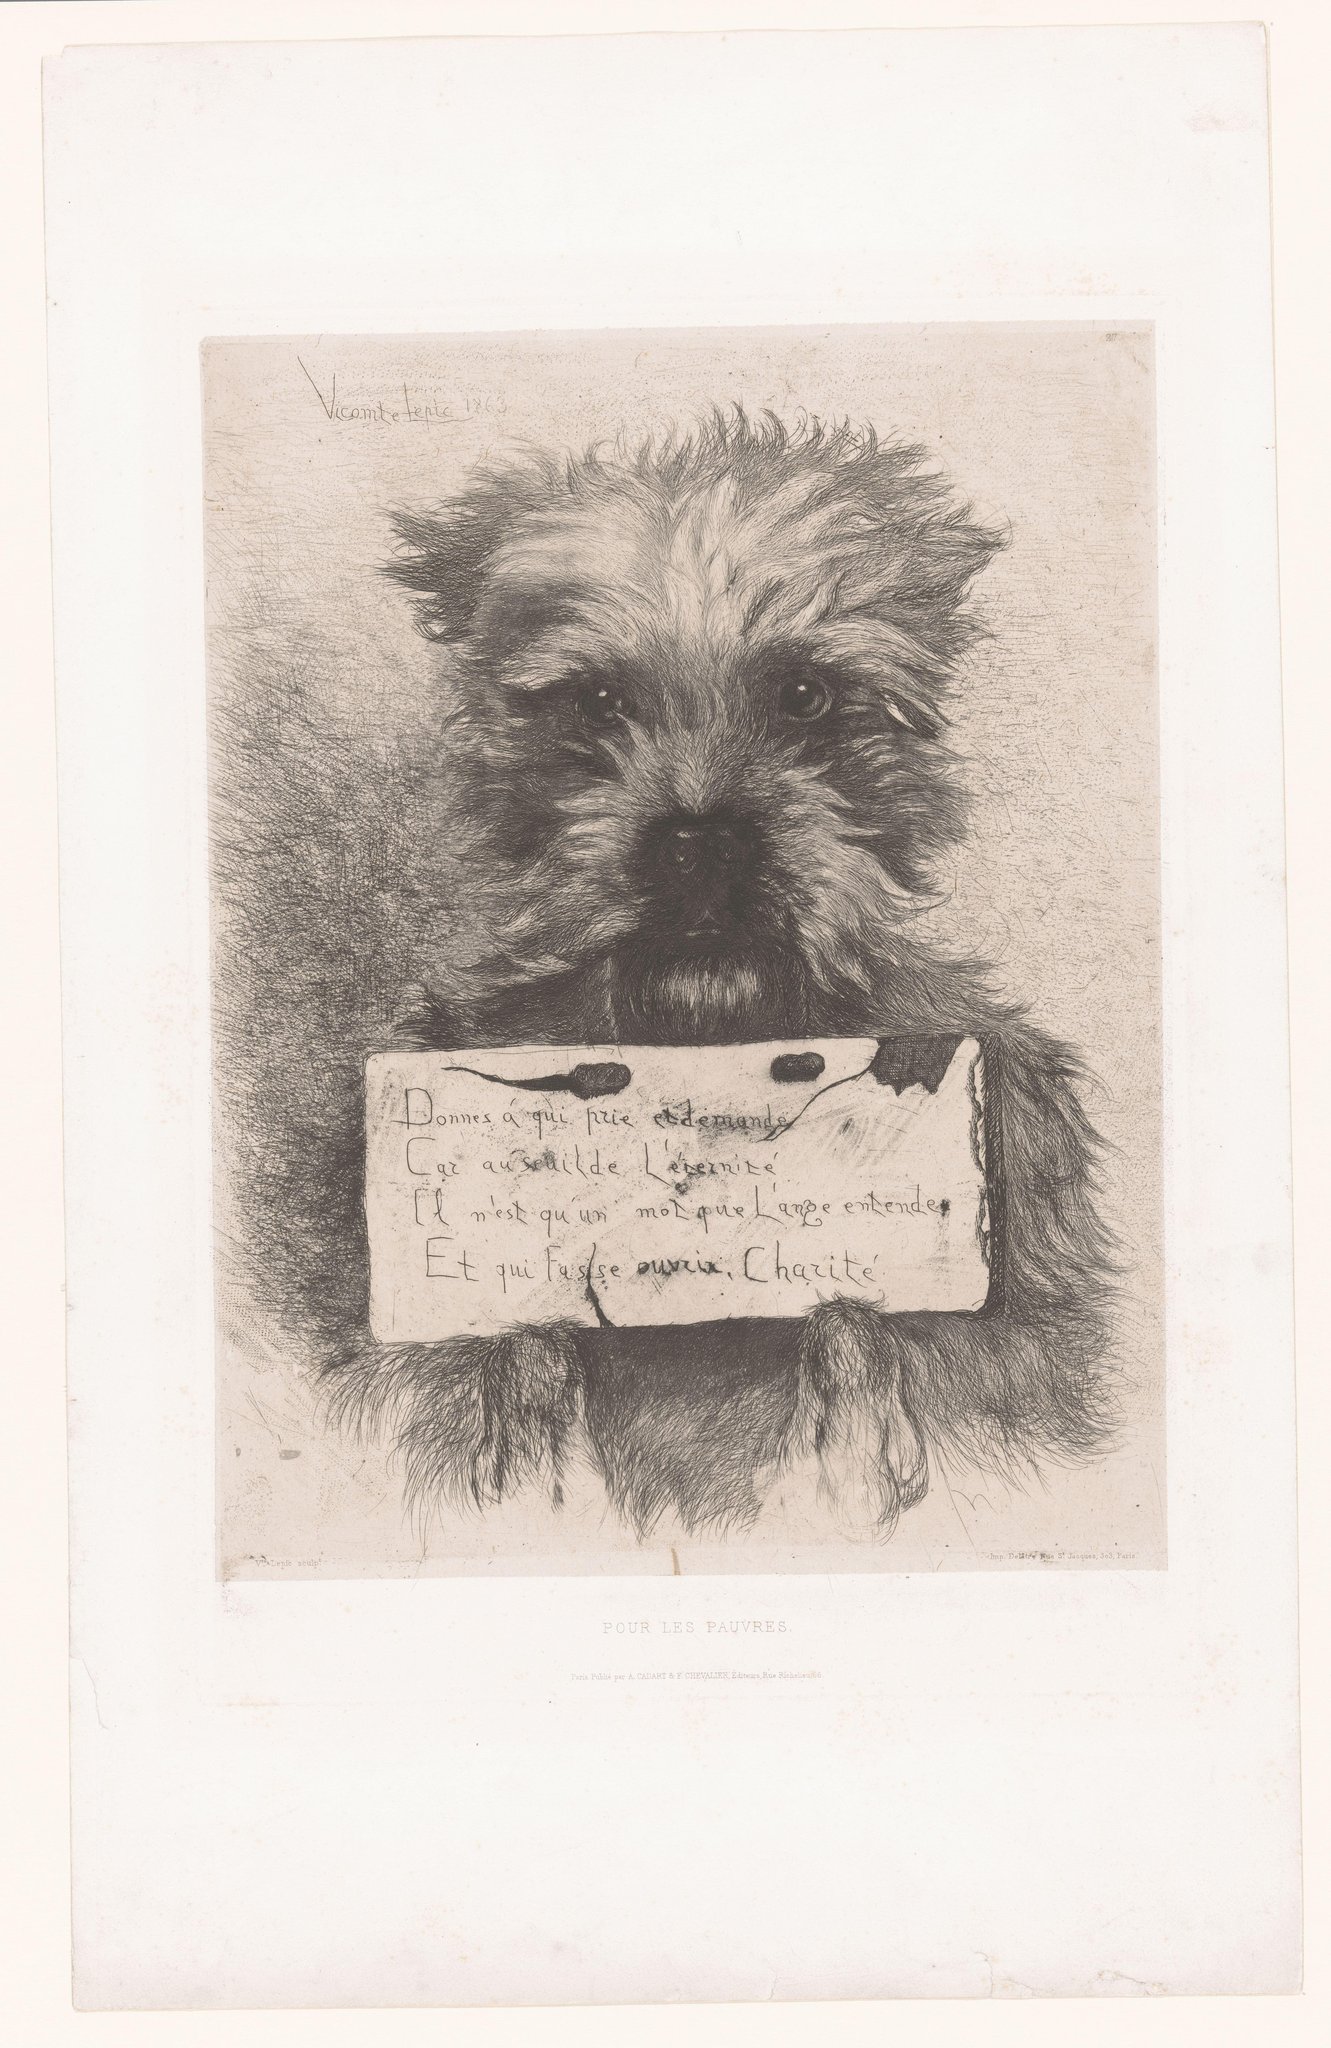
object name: print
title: Pour les Pauvres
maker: ludovic napoléon lepic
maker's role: print maker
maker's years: 1839-1889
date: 1863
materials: paper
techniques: etching, roulette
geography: paris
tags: dog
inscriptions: date